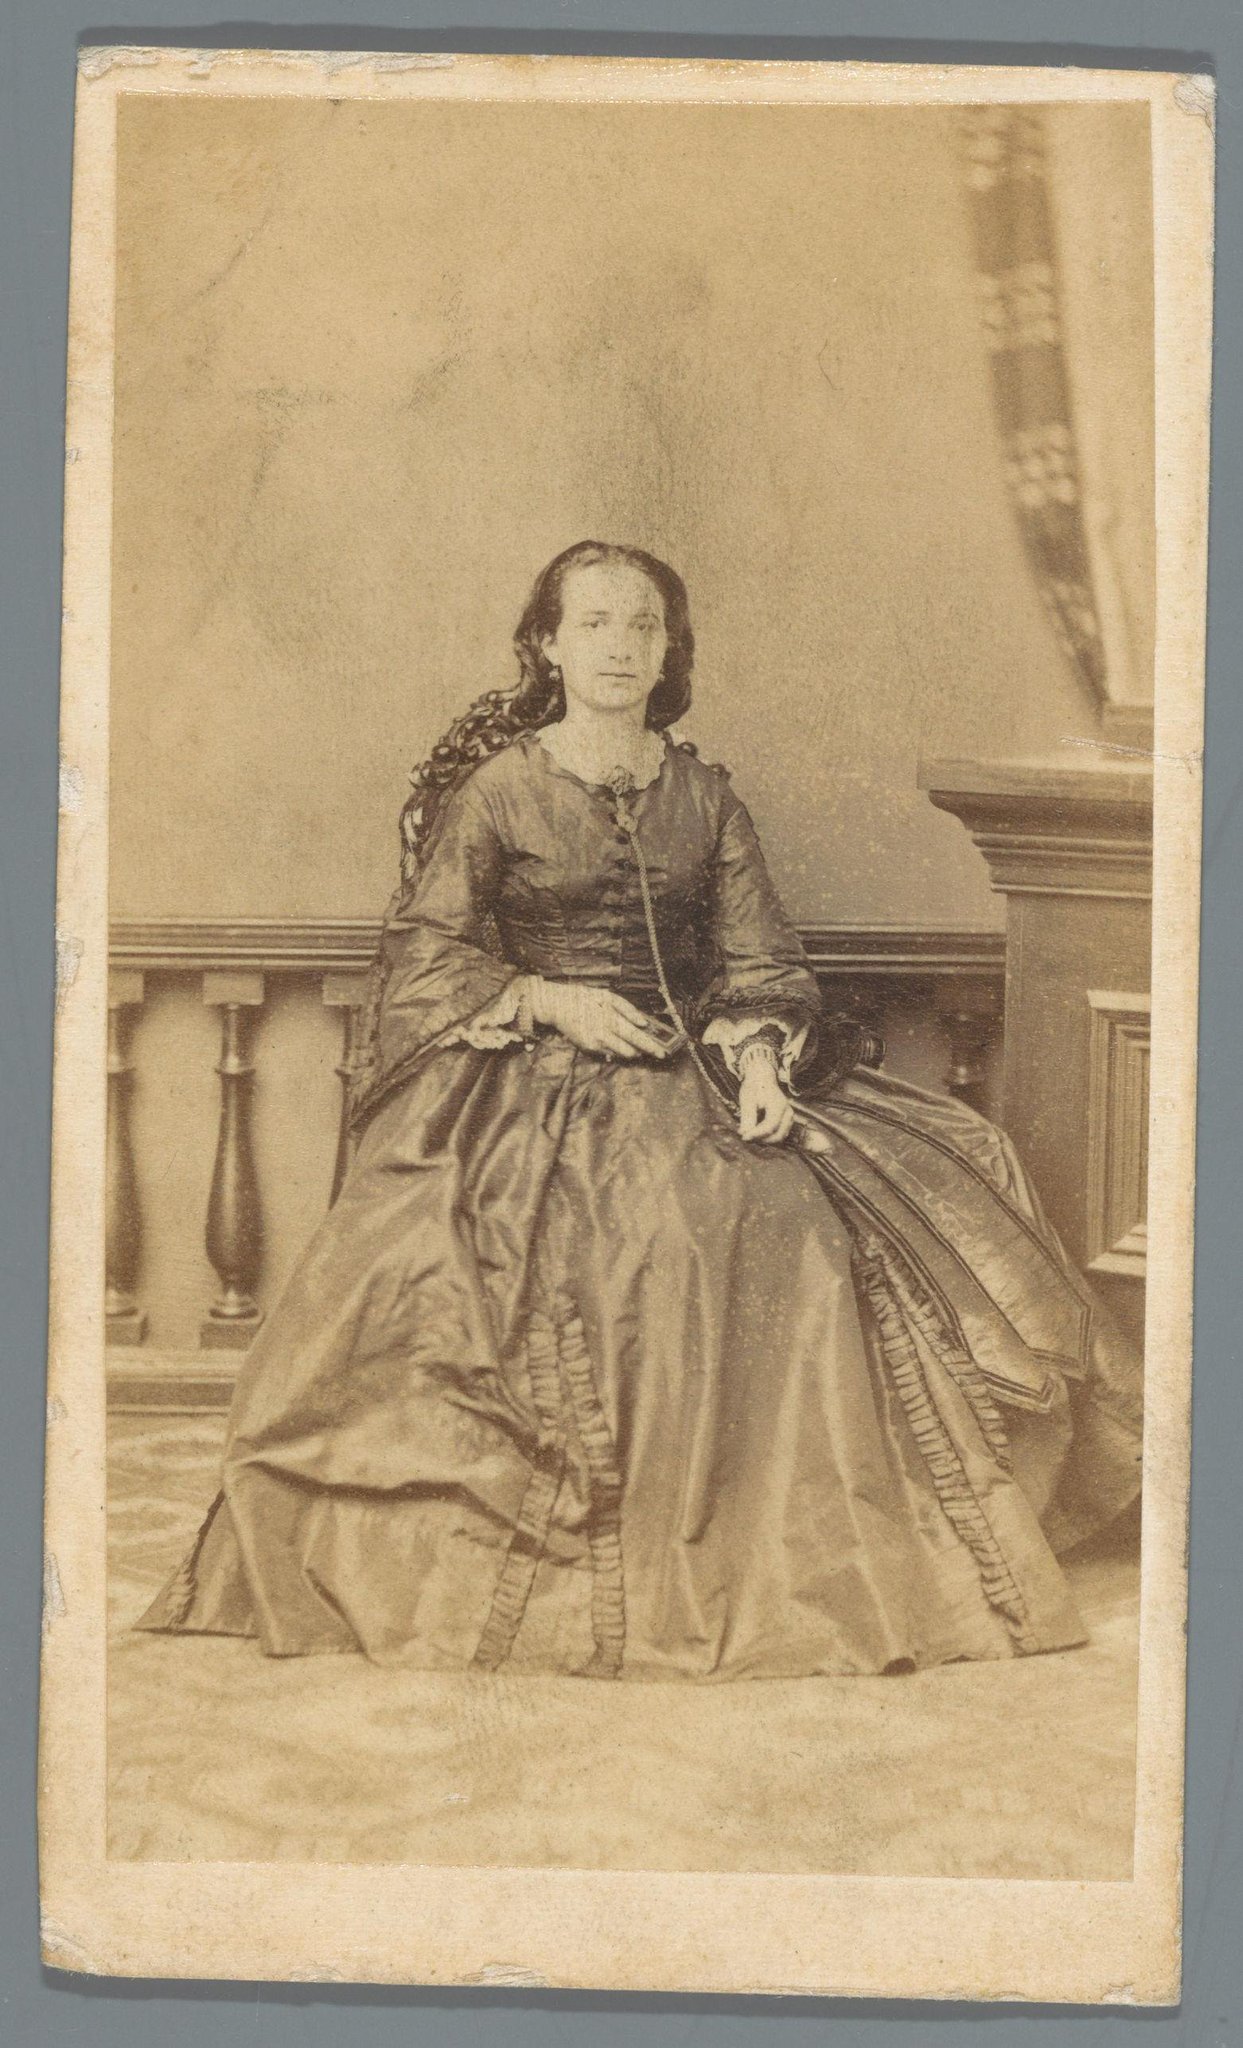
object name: photograph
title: Portret van een onbekende vrouw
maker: Anonymous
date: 1855-1885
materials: cardboard, paper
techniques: albumen print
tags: adult woman, anonymous historical person portrayed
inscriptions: inscription: ‘Je tiens à toi’